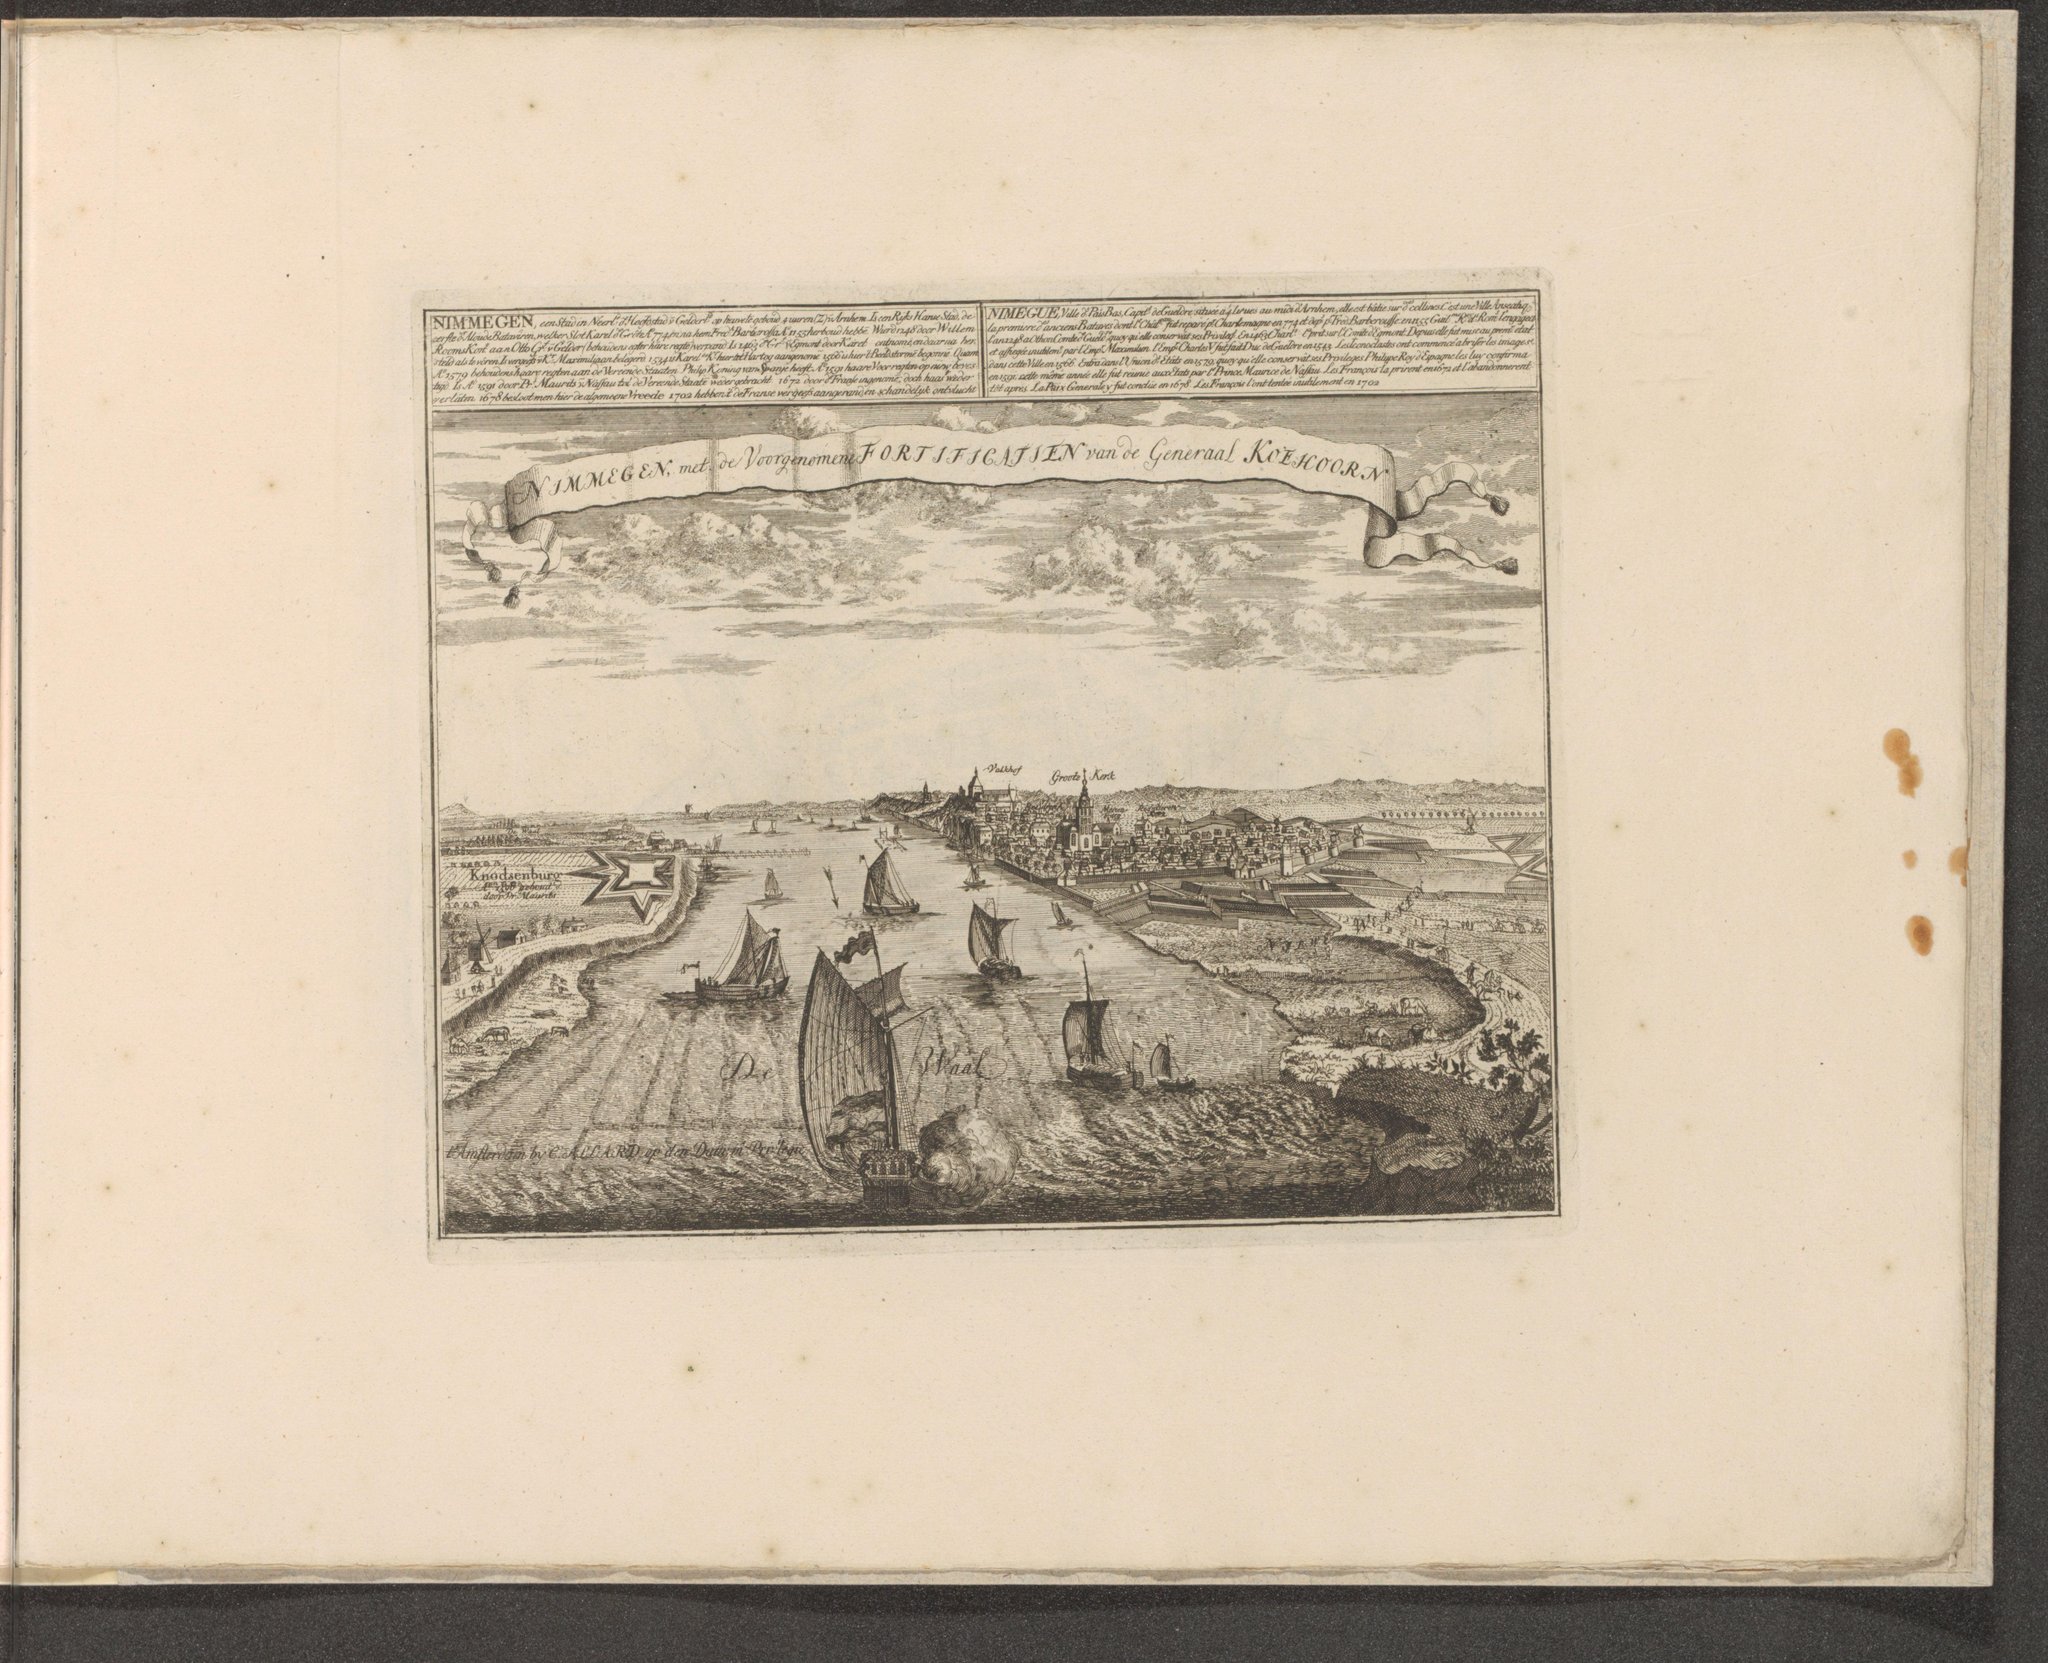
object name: print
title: Les Principales Forteresses & Villes Fortes, d'Espagne, de France, d'Italie, de Savoië, d'Allemagne & des Païs-Bas (...) / Naaukeurige Afbeeldingen der Voornaamste Sterke Steden en Vestingen in Spanjen, Vrankryk, Italien, Savoyen, Duytsland en Nederlanden (...)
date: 1702-1733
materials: paper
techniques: etching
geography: leiden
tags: fortifications, military engineering, maps of cities, nijmegen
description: Gezicht op de Waal en Nijmegen. Links het fort Knodsenburg. Met teksten in het Nederlands en Frans. De tekst refereert aan de mislukte aanval van de Fransen in 1702. De prent maakt deel uit van een album.